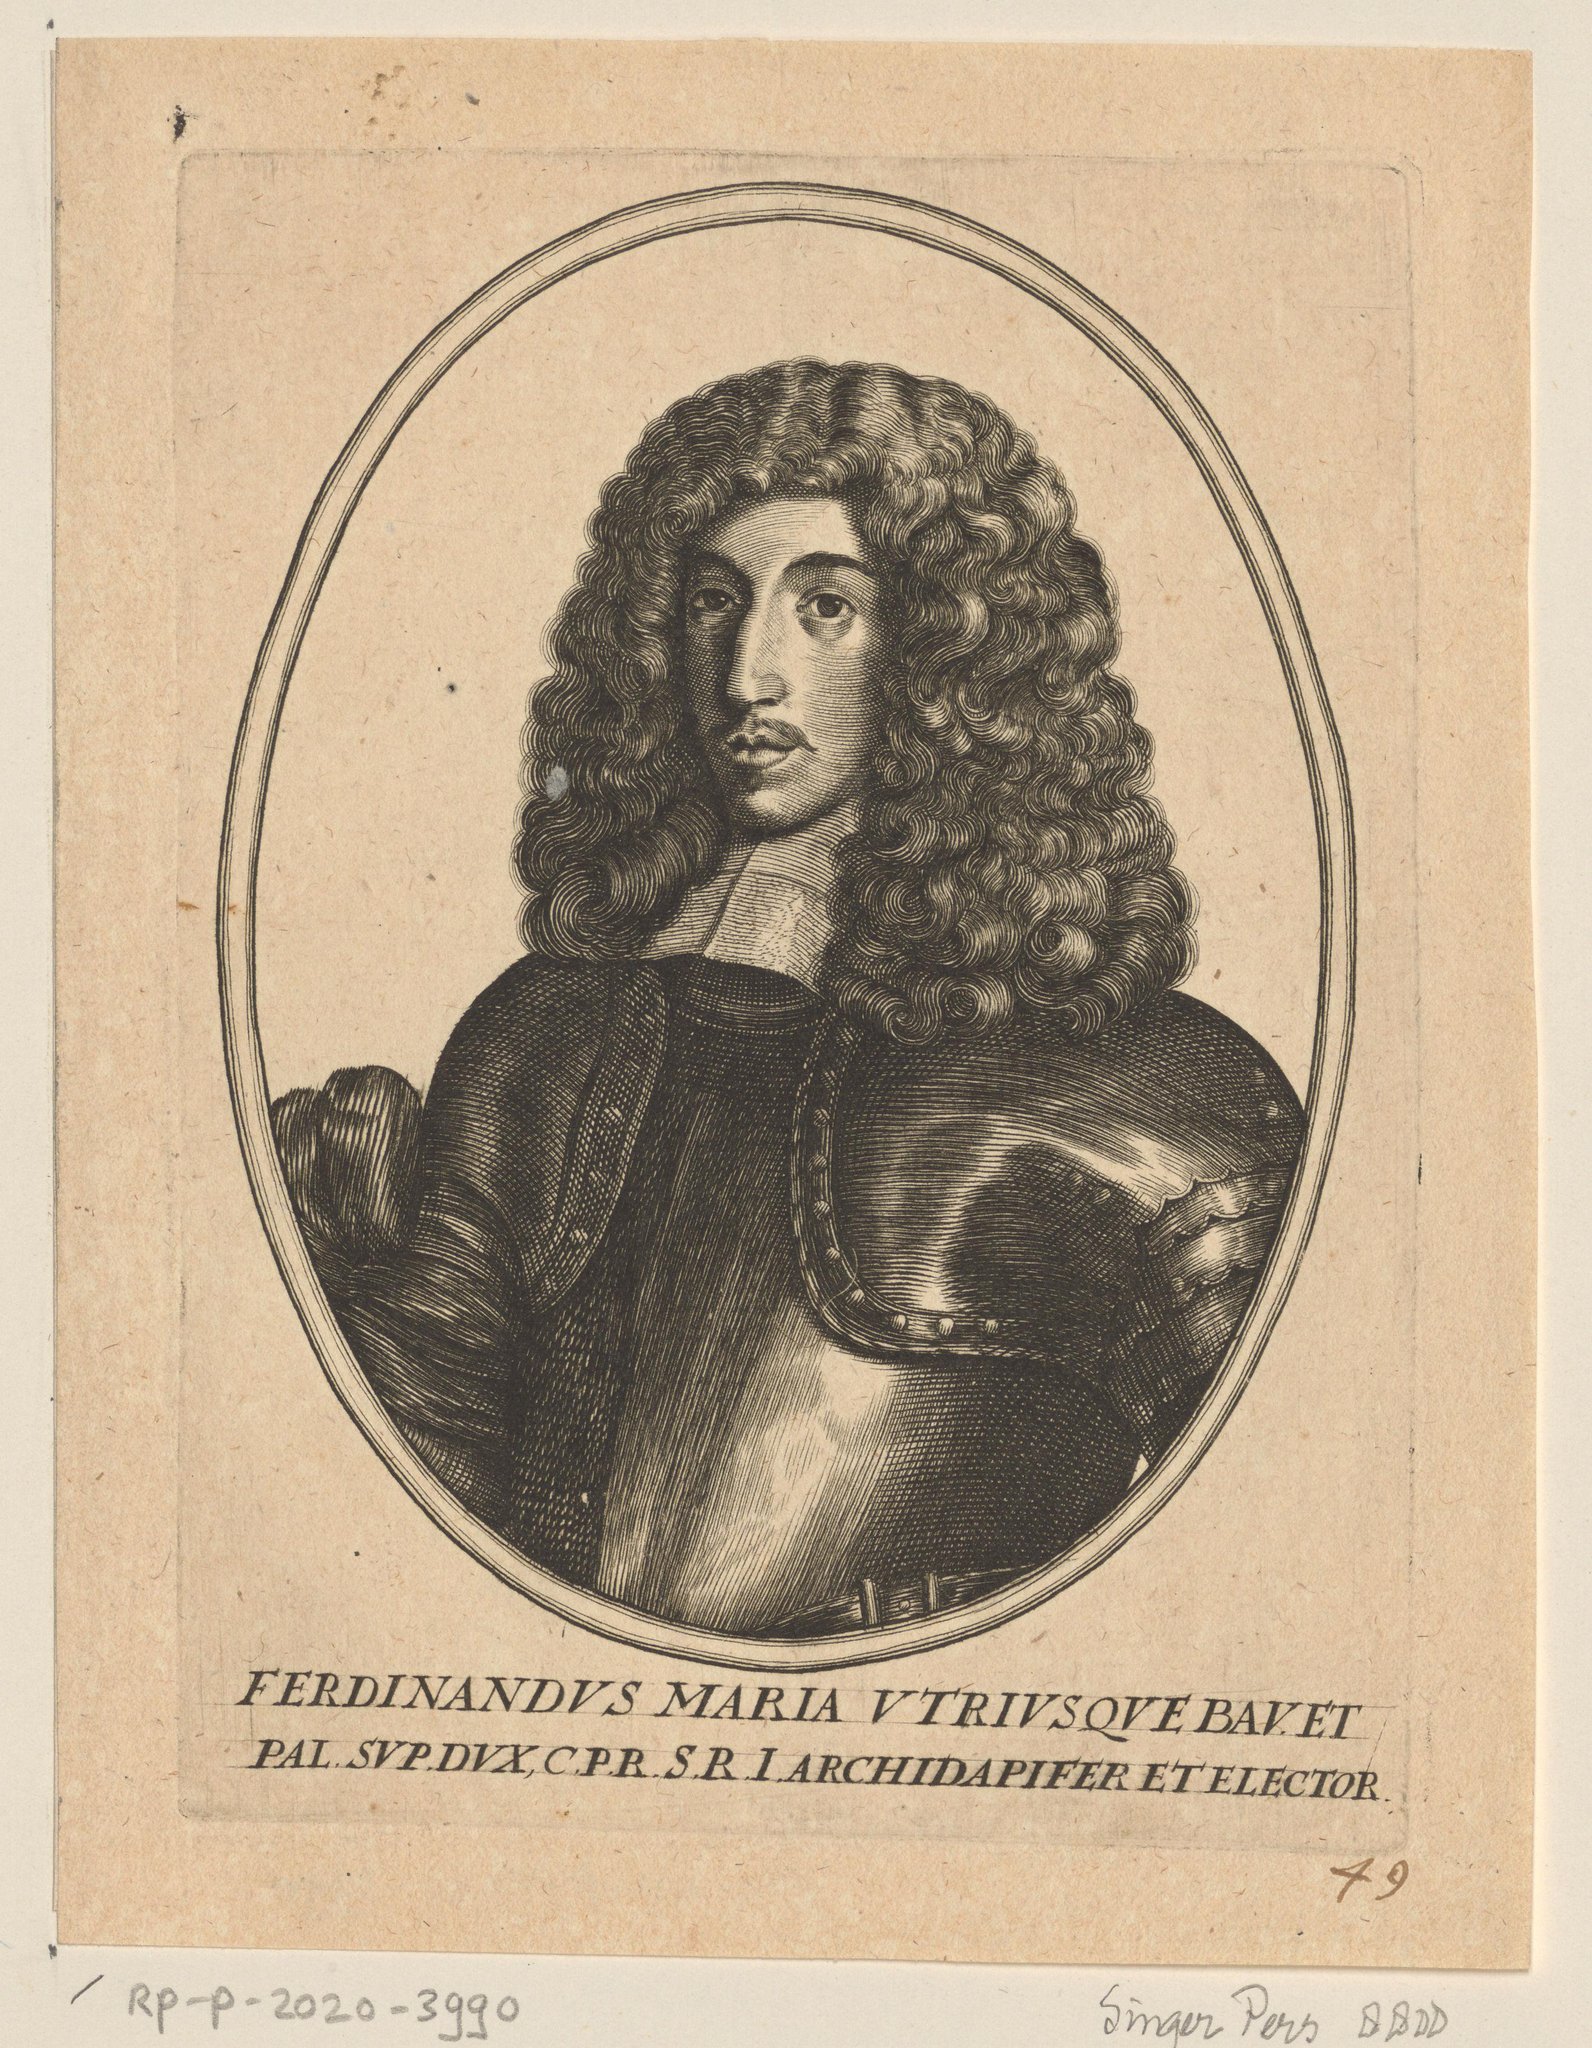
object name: print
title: Portret van Ferdinand Maria van Beieren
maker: Anonymous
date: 1660-1700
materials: paper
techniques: engraving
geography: germany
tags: ferdinand maria keurvorst van beieren, armour, historical persons